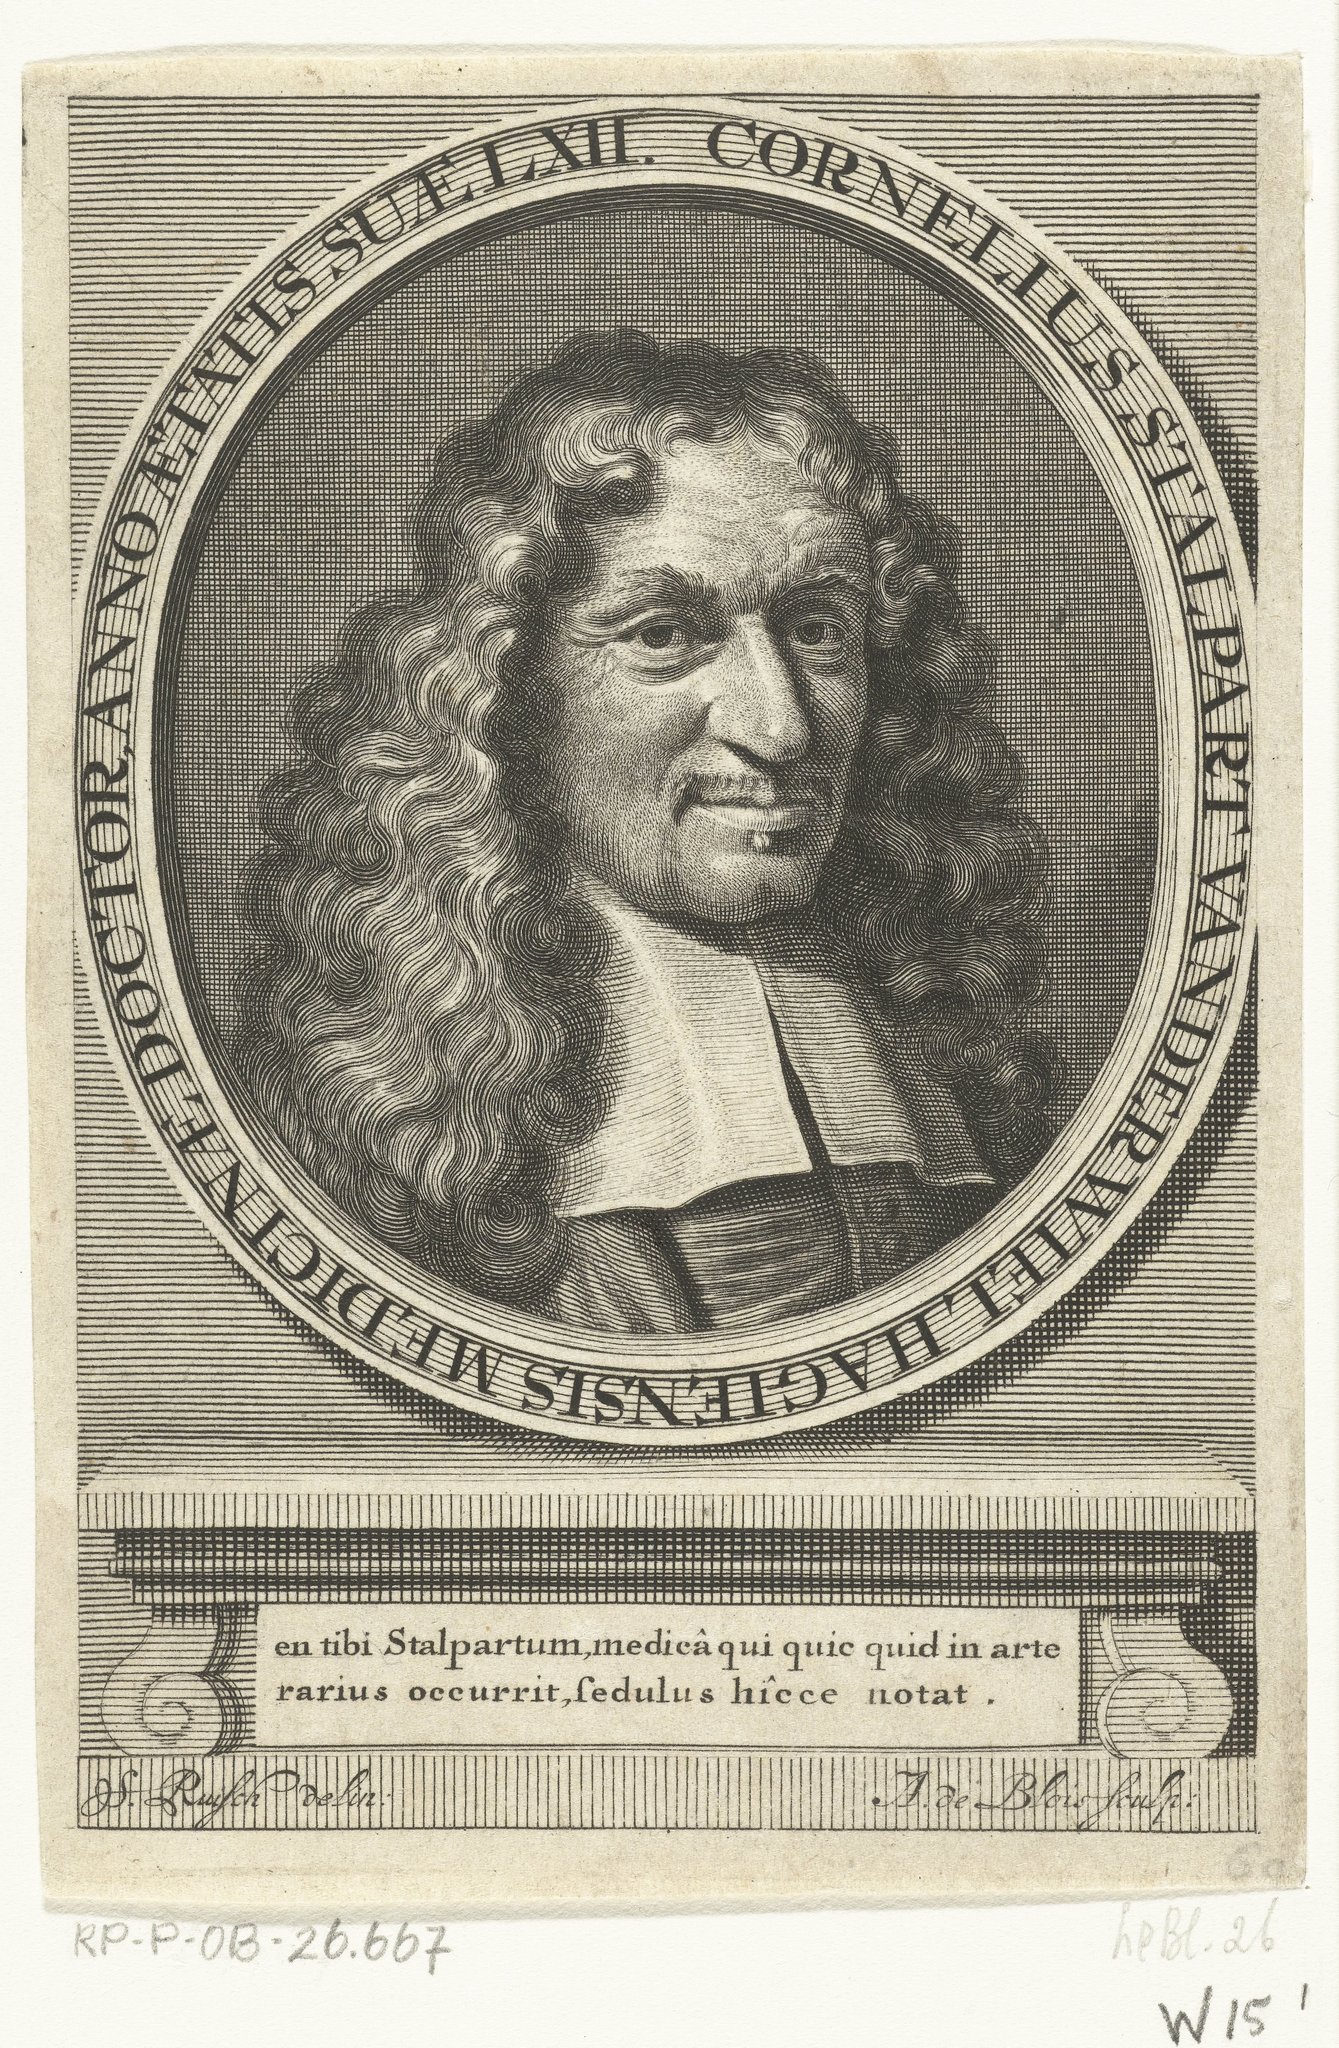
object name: print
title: Cornelius Stalpart van der Wiel Hagiensis medicinae doctor anno aetatis suae LXII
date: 1679-1682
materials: paper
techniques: engraving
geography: amsterdam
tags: physician, doctor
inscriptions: collector's mark: Lugt 2228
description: Portret van de Haagse doctor Cornelis Stalpart vander Wiel op 62-jarige leeftijd in ovale omlijsting met twee regels Latijnse tekst op console.